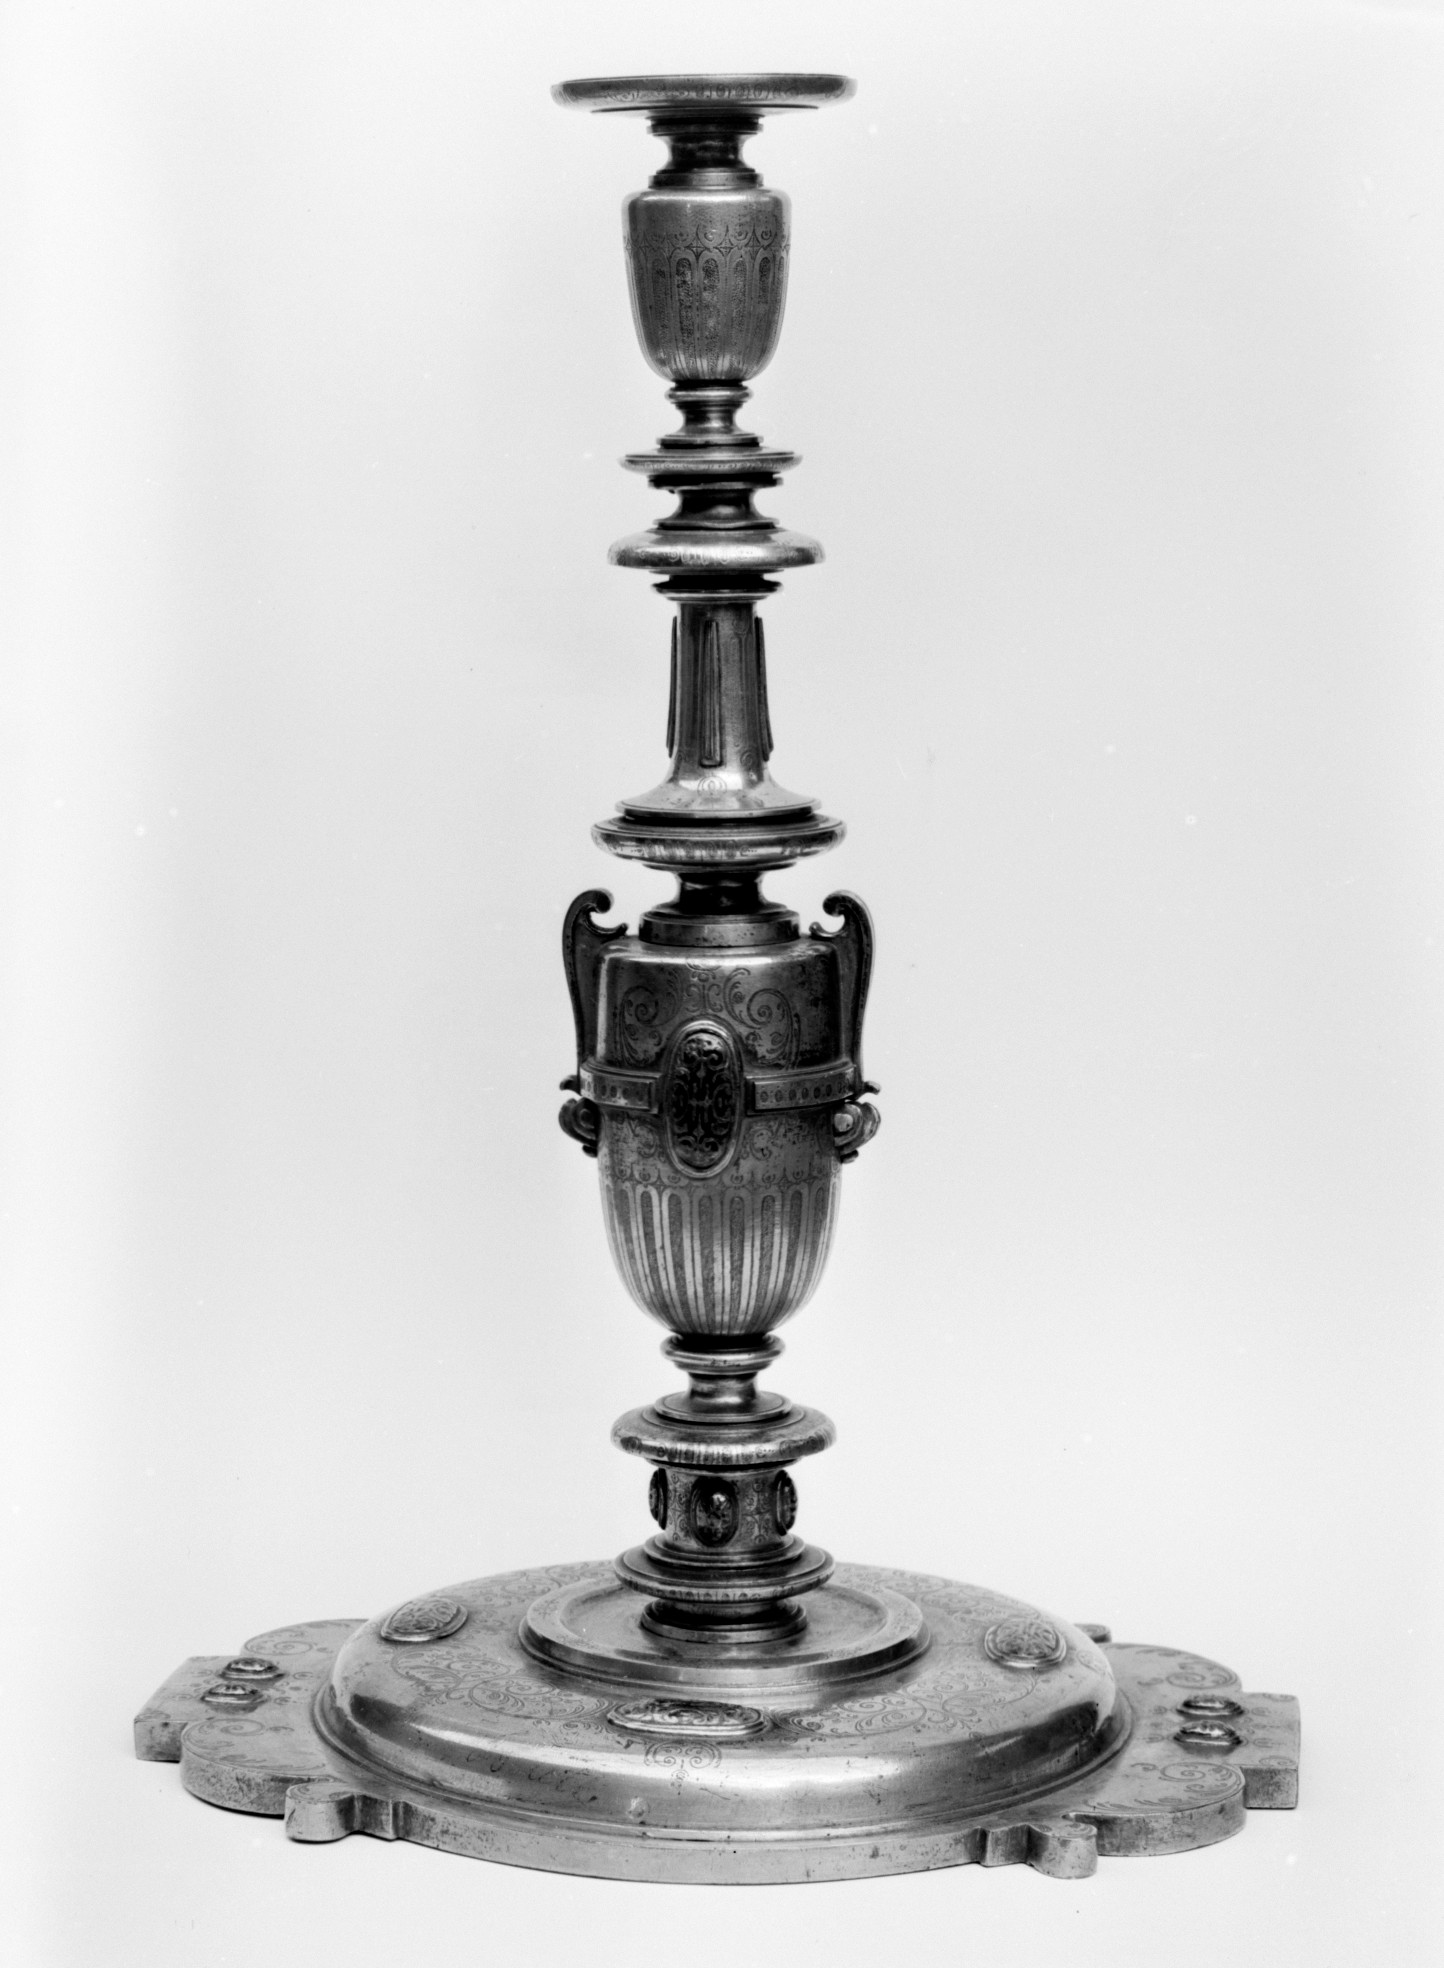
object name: candlestick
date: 1601-1650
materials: enamel, gilt bronze